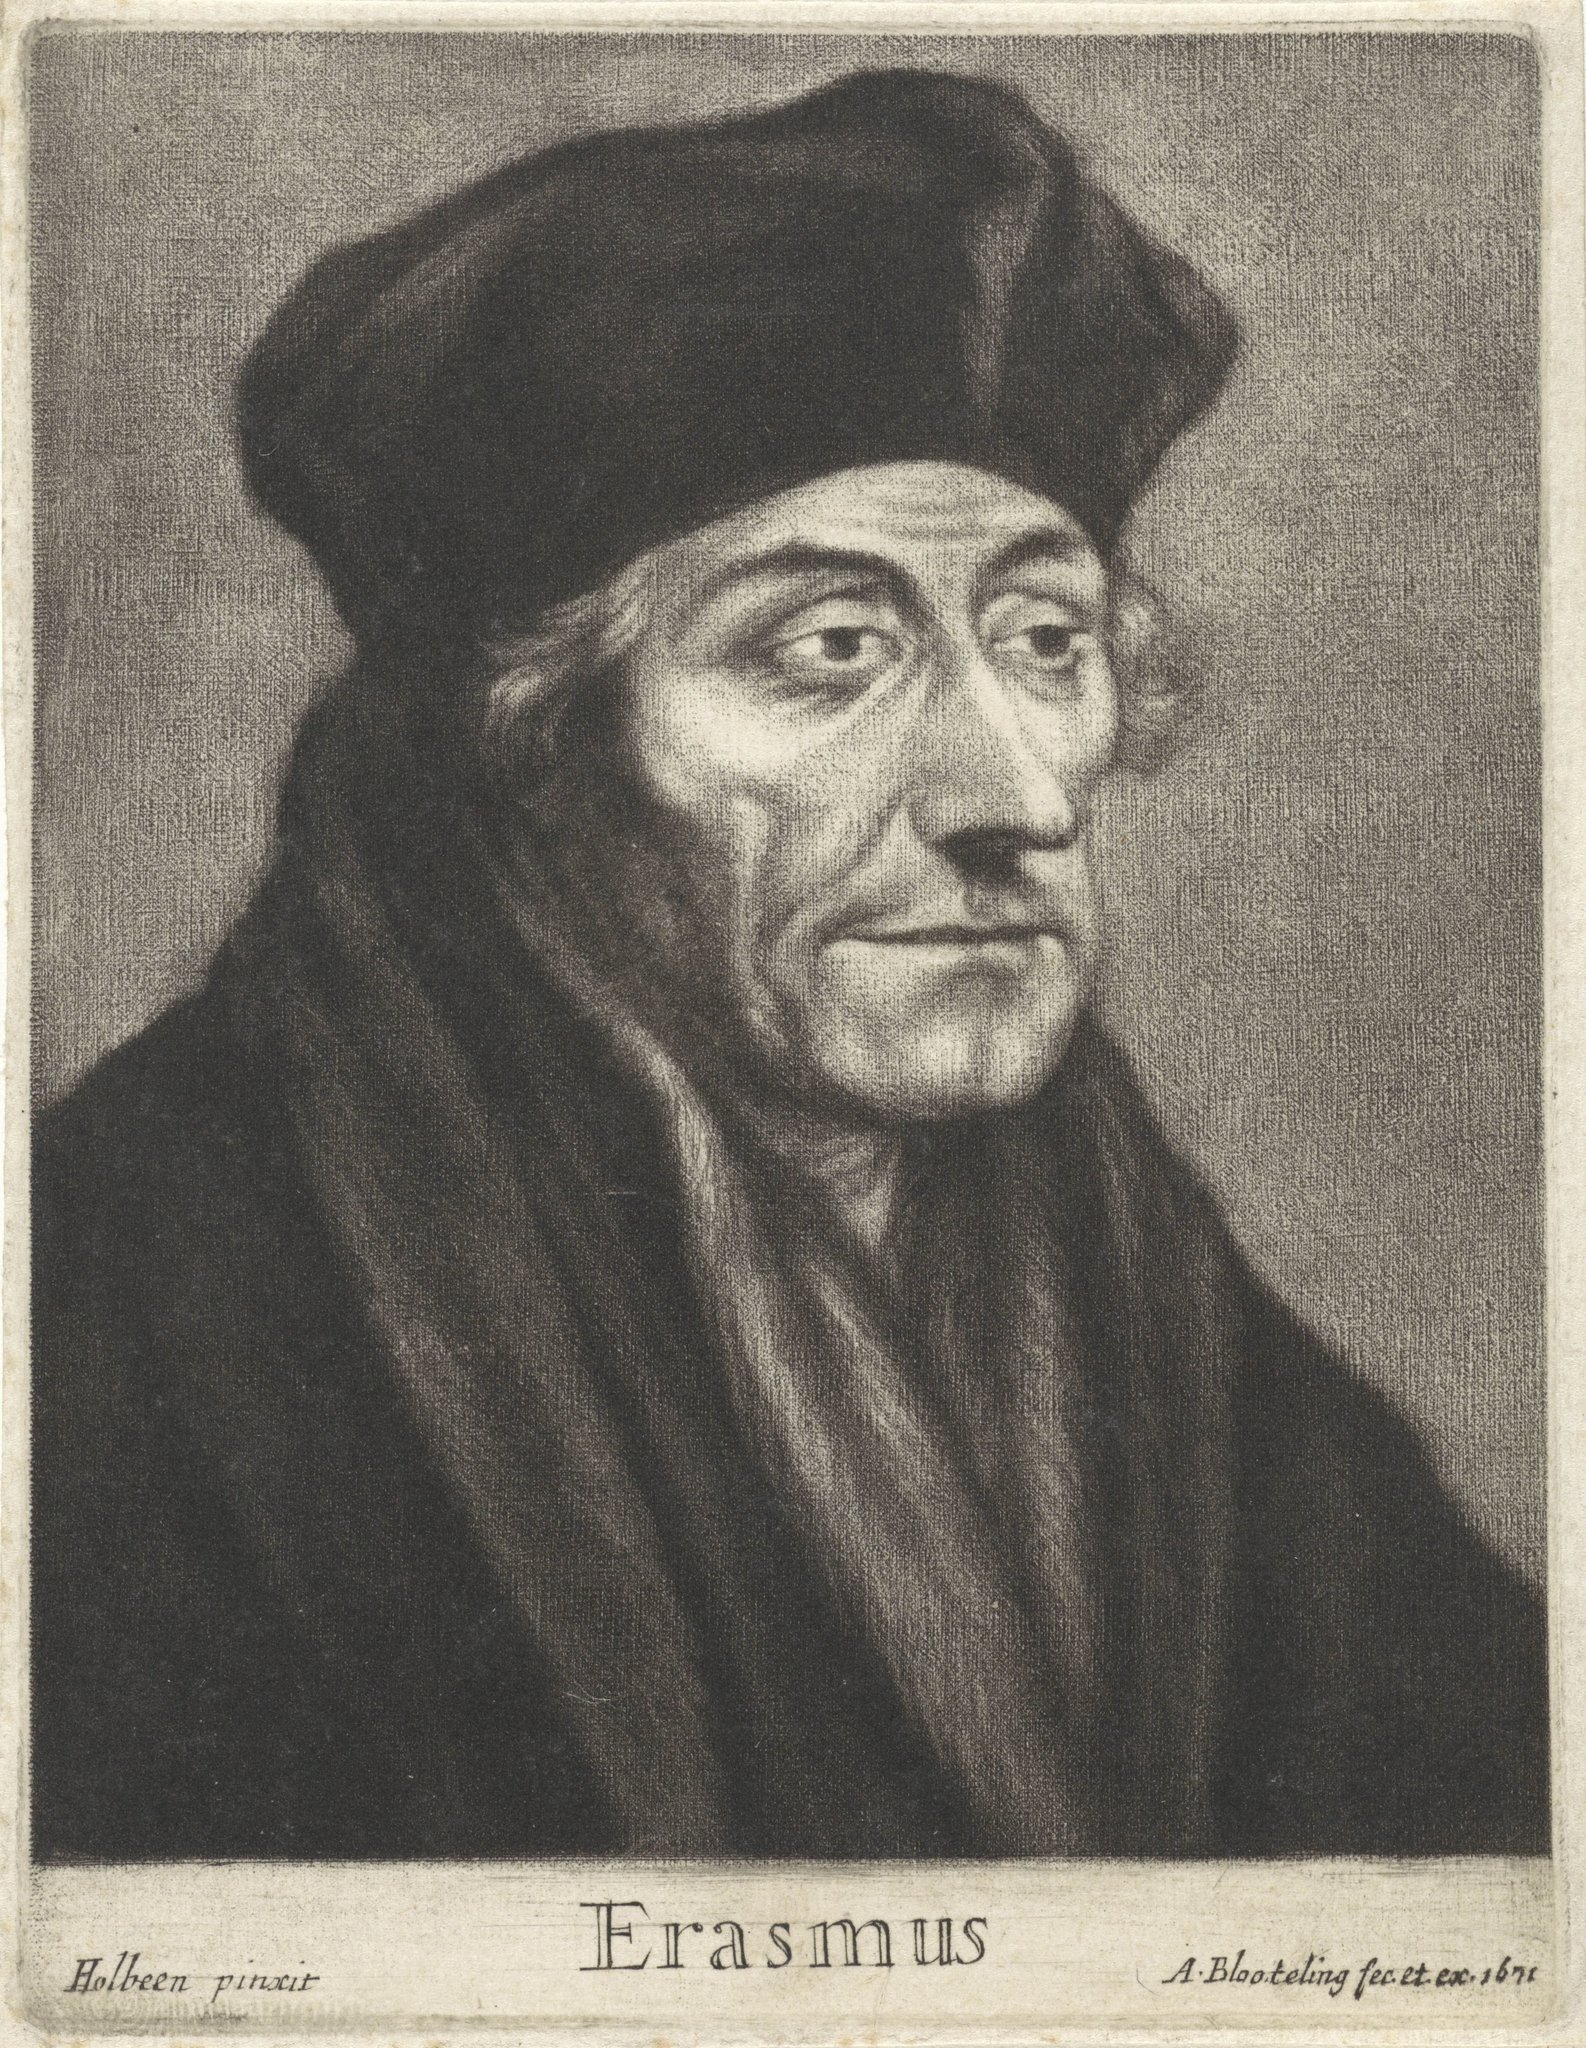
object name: print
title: Portret van Desiderius Erasmus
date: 1671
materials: paper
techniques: engraving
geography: amsterdam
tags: rotterdam, desiderius erasmus, historical persons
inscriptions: collector's mark: Lugt 2228, :